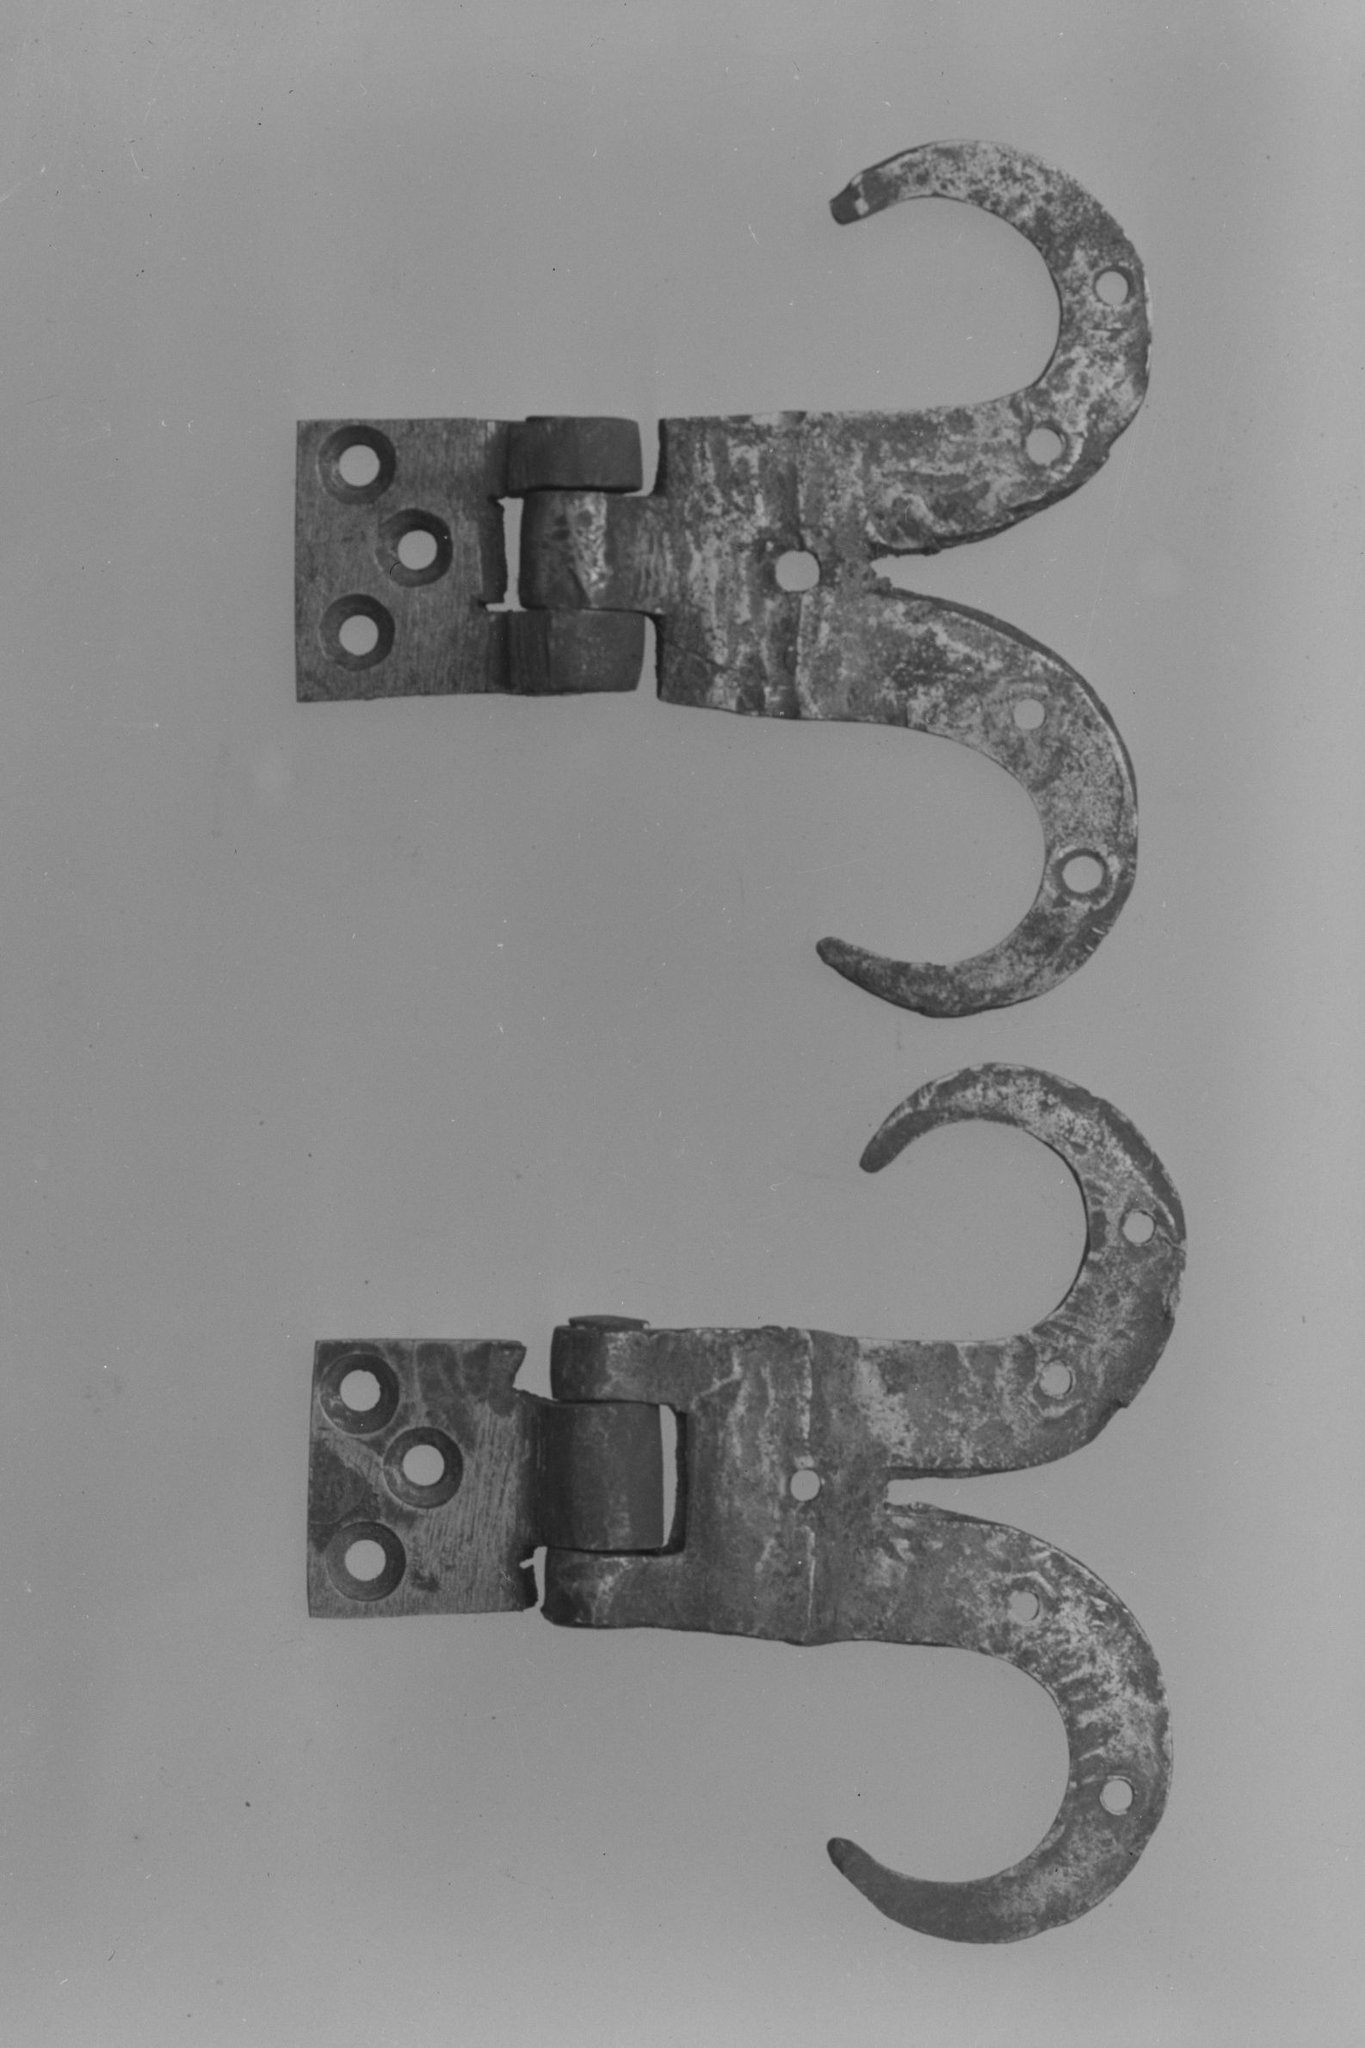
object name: hinge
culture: american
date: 1700-1800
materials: iron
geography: united states